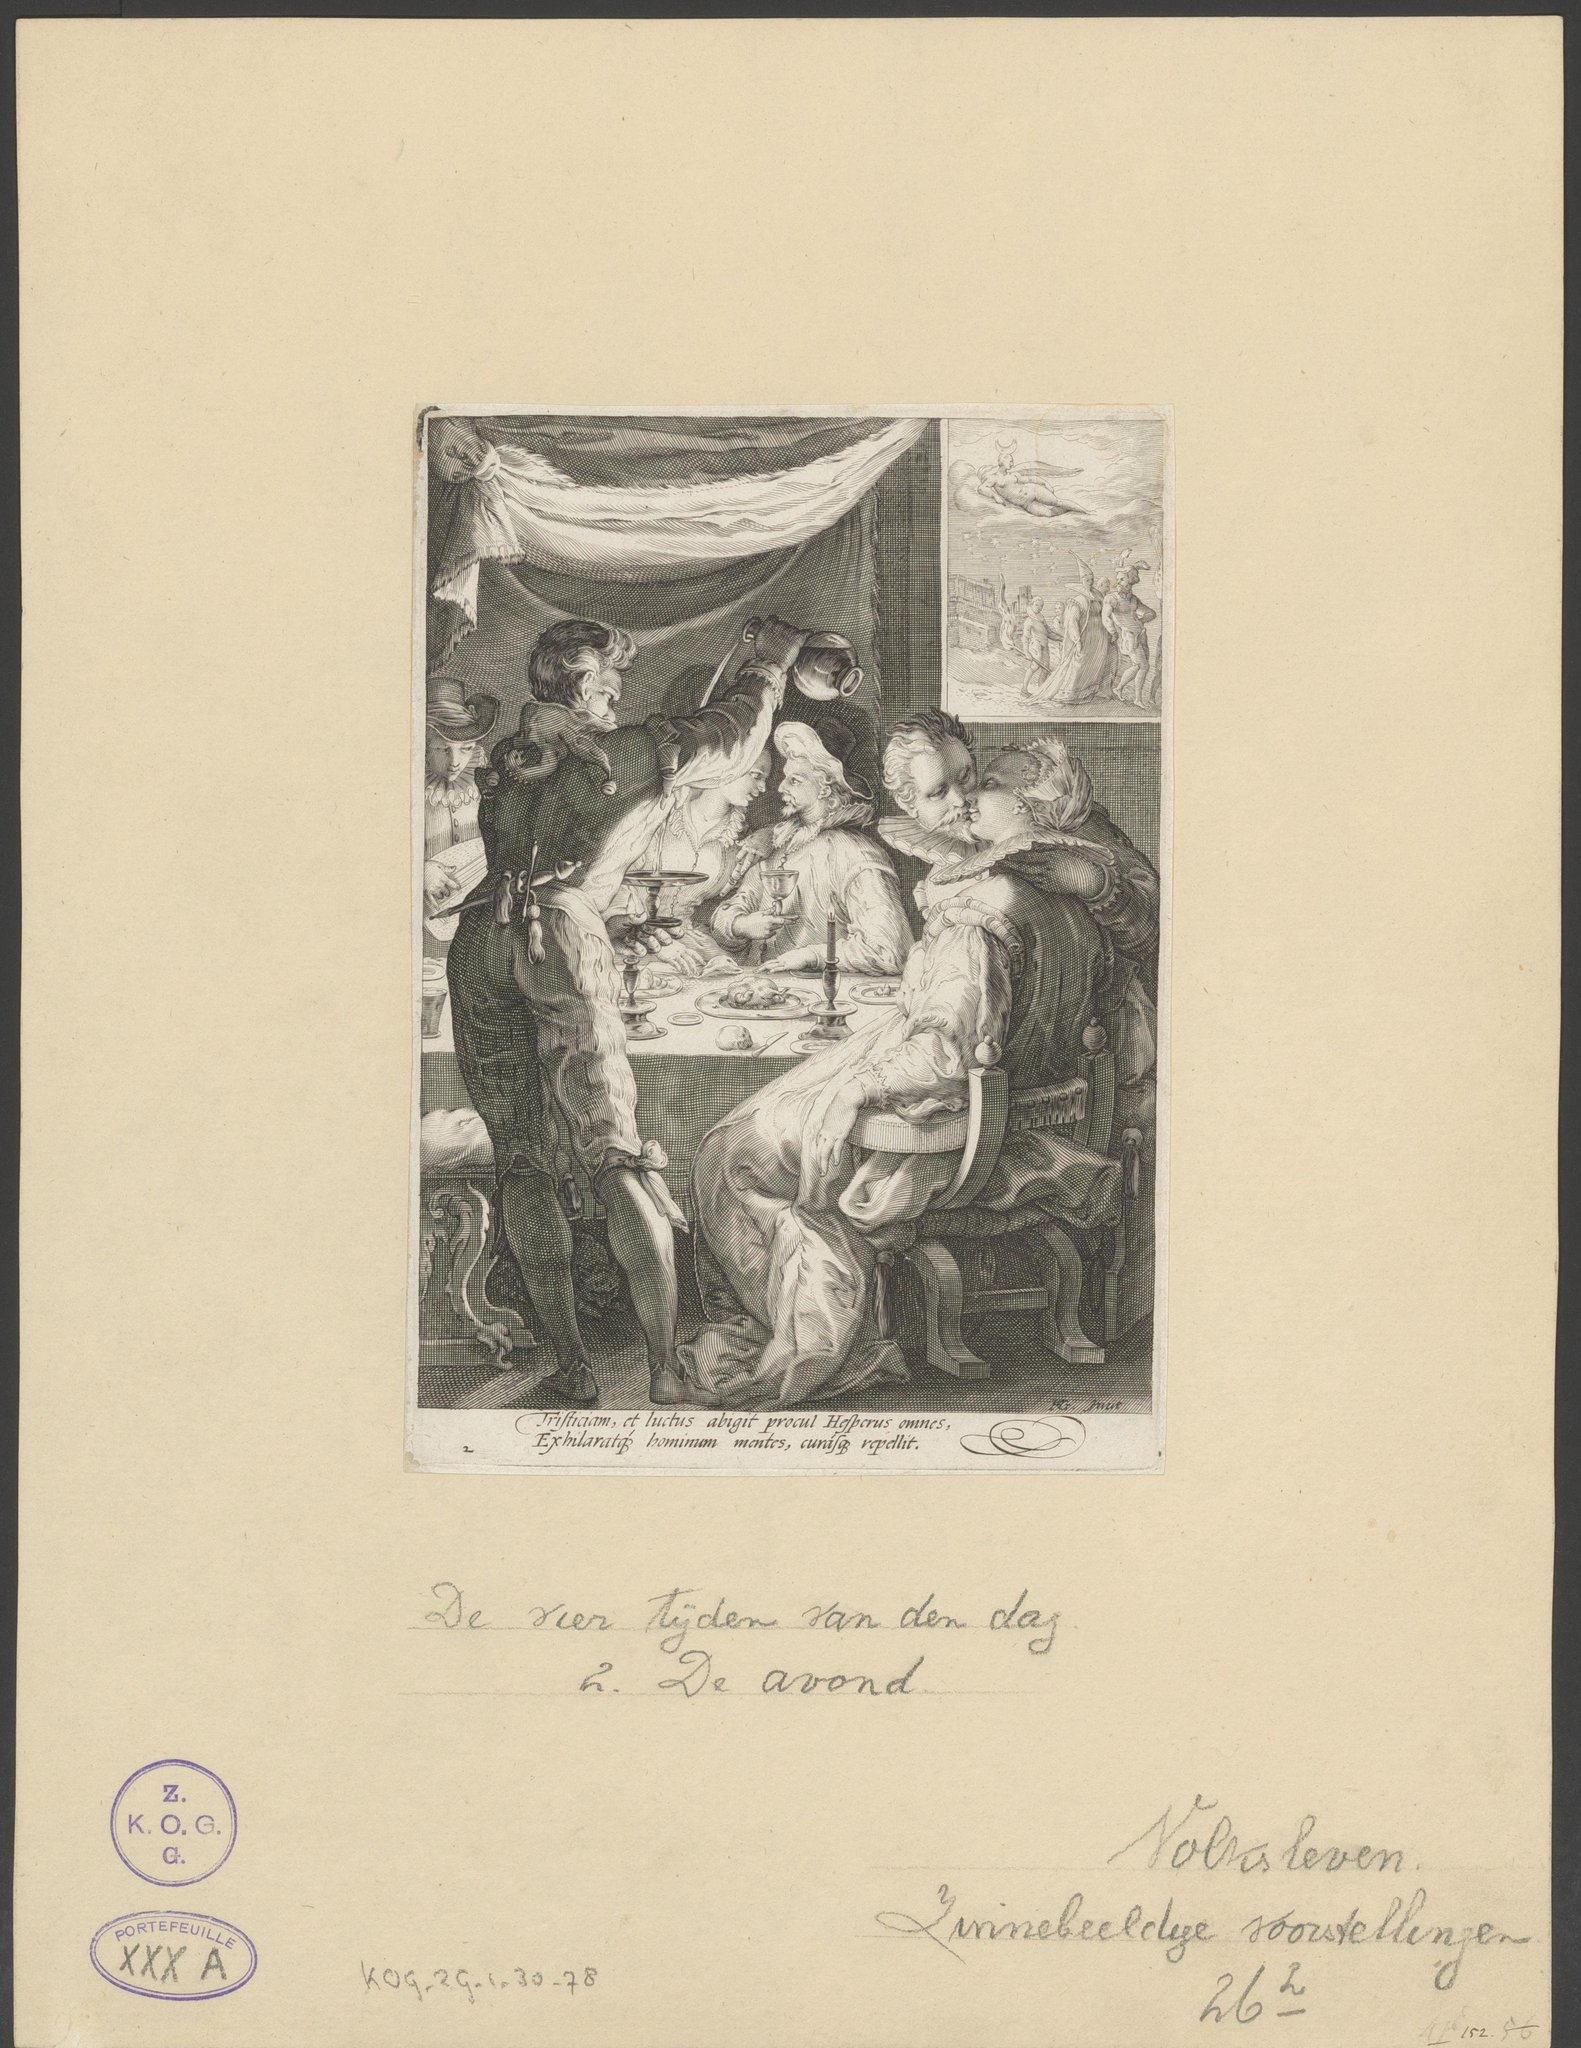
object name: print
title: Vier tijden van de dag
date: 1575-1607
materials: paper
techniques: engraving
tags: diana lucina, evening, banquet of elegant company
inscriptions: collector's mark: Lugt 963, stamp:, collector's mark: Lugt 1641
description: Elegant gezelschap aan een rijk gevulde tafel. Een bediende, op de rug gezien, schenkt wijn in. Door een venster is de godin Diana te zien op een wolk boven een feestvierend gezelschap op straat. Onderaan een tweeregelig vers in het Latijn. Rechtsonder genummerd: 2. Onderwerpsrubrieken binnen de Atlas Zeden en Gewoonten: Zeden en Gewoonten in engeren zin. Volksleven. Zinnebeeldige voorstellingen uit het volkleven op serieprenten. Maanden en diversen (allegorieën).